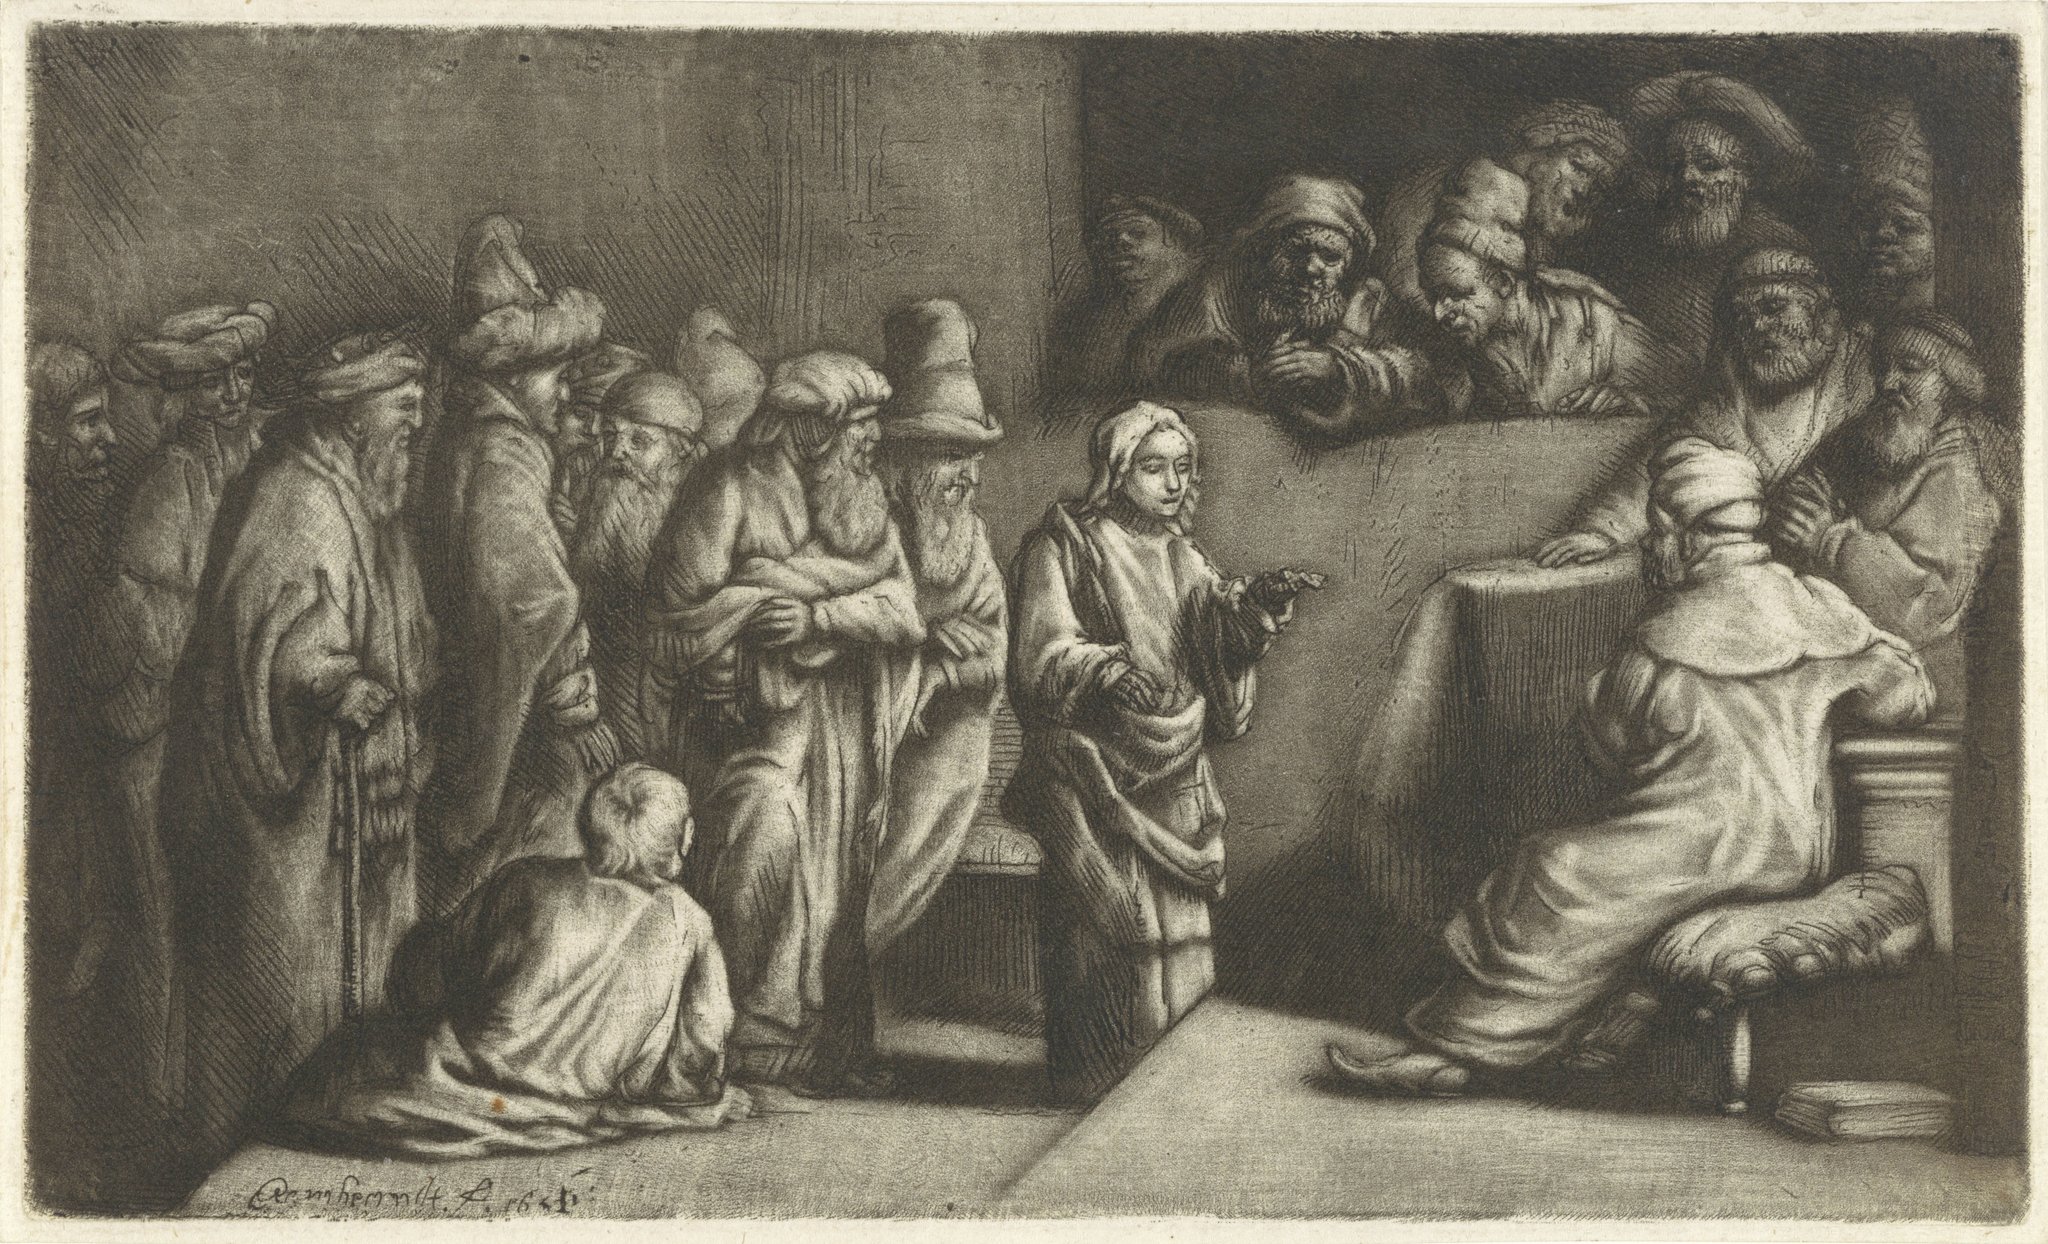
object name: print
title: Christ disputing with the Doctors: a sketch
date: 1652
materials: paper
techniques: etching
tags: christ's dispute with the doctors in the temple; he counts his arguments on his fingers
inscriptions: collector's mark: Lugt 2228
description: De twaalfjarige Christus bevindt zich tussen geleerden in de tempel en stelt hen vragen.